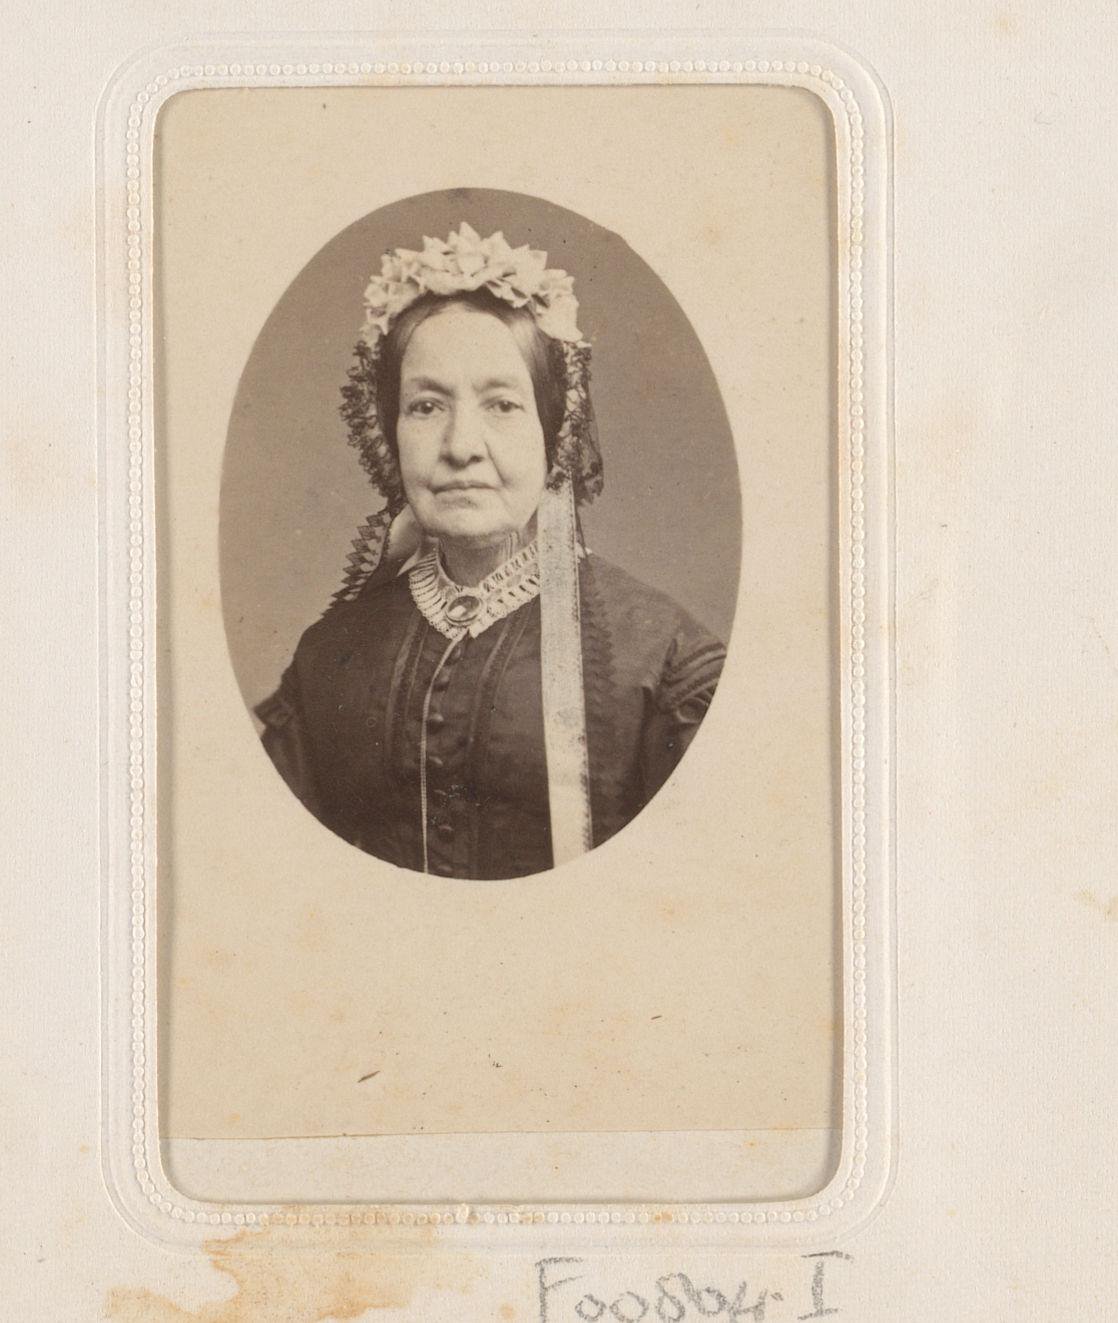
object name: album leaf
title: Portret van een vrouw met een hoofddeksel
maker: charles binger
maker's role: print maker, printer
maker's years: 1830-1916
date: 1862-1869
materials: cardboard, photographic support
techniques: albumen print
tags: adult woman, head-gear, historical persons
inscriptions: inscription: ‘CH. Binger & Co./ Photographische inrigting/ Zijlstrat/ te/Haarlem’